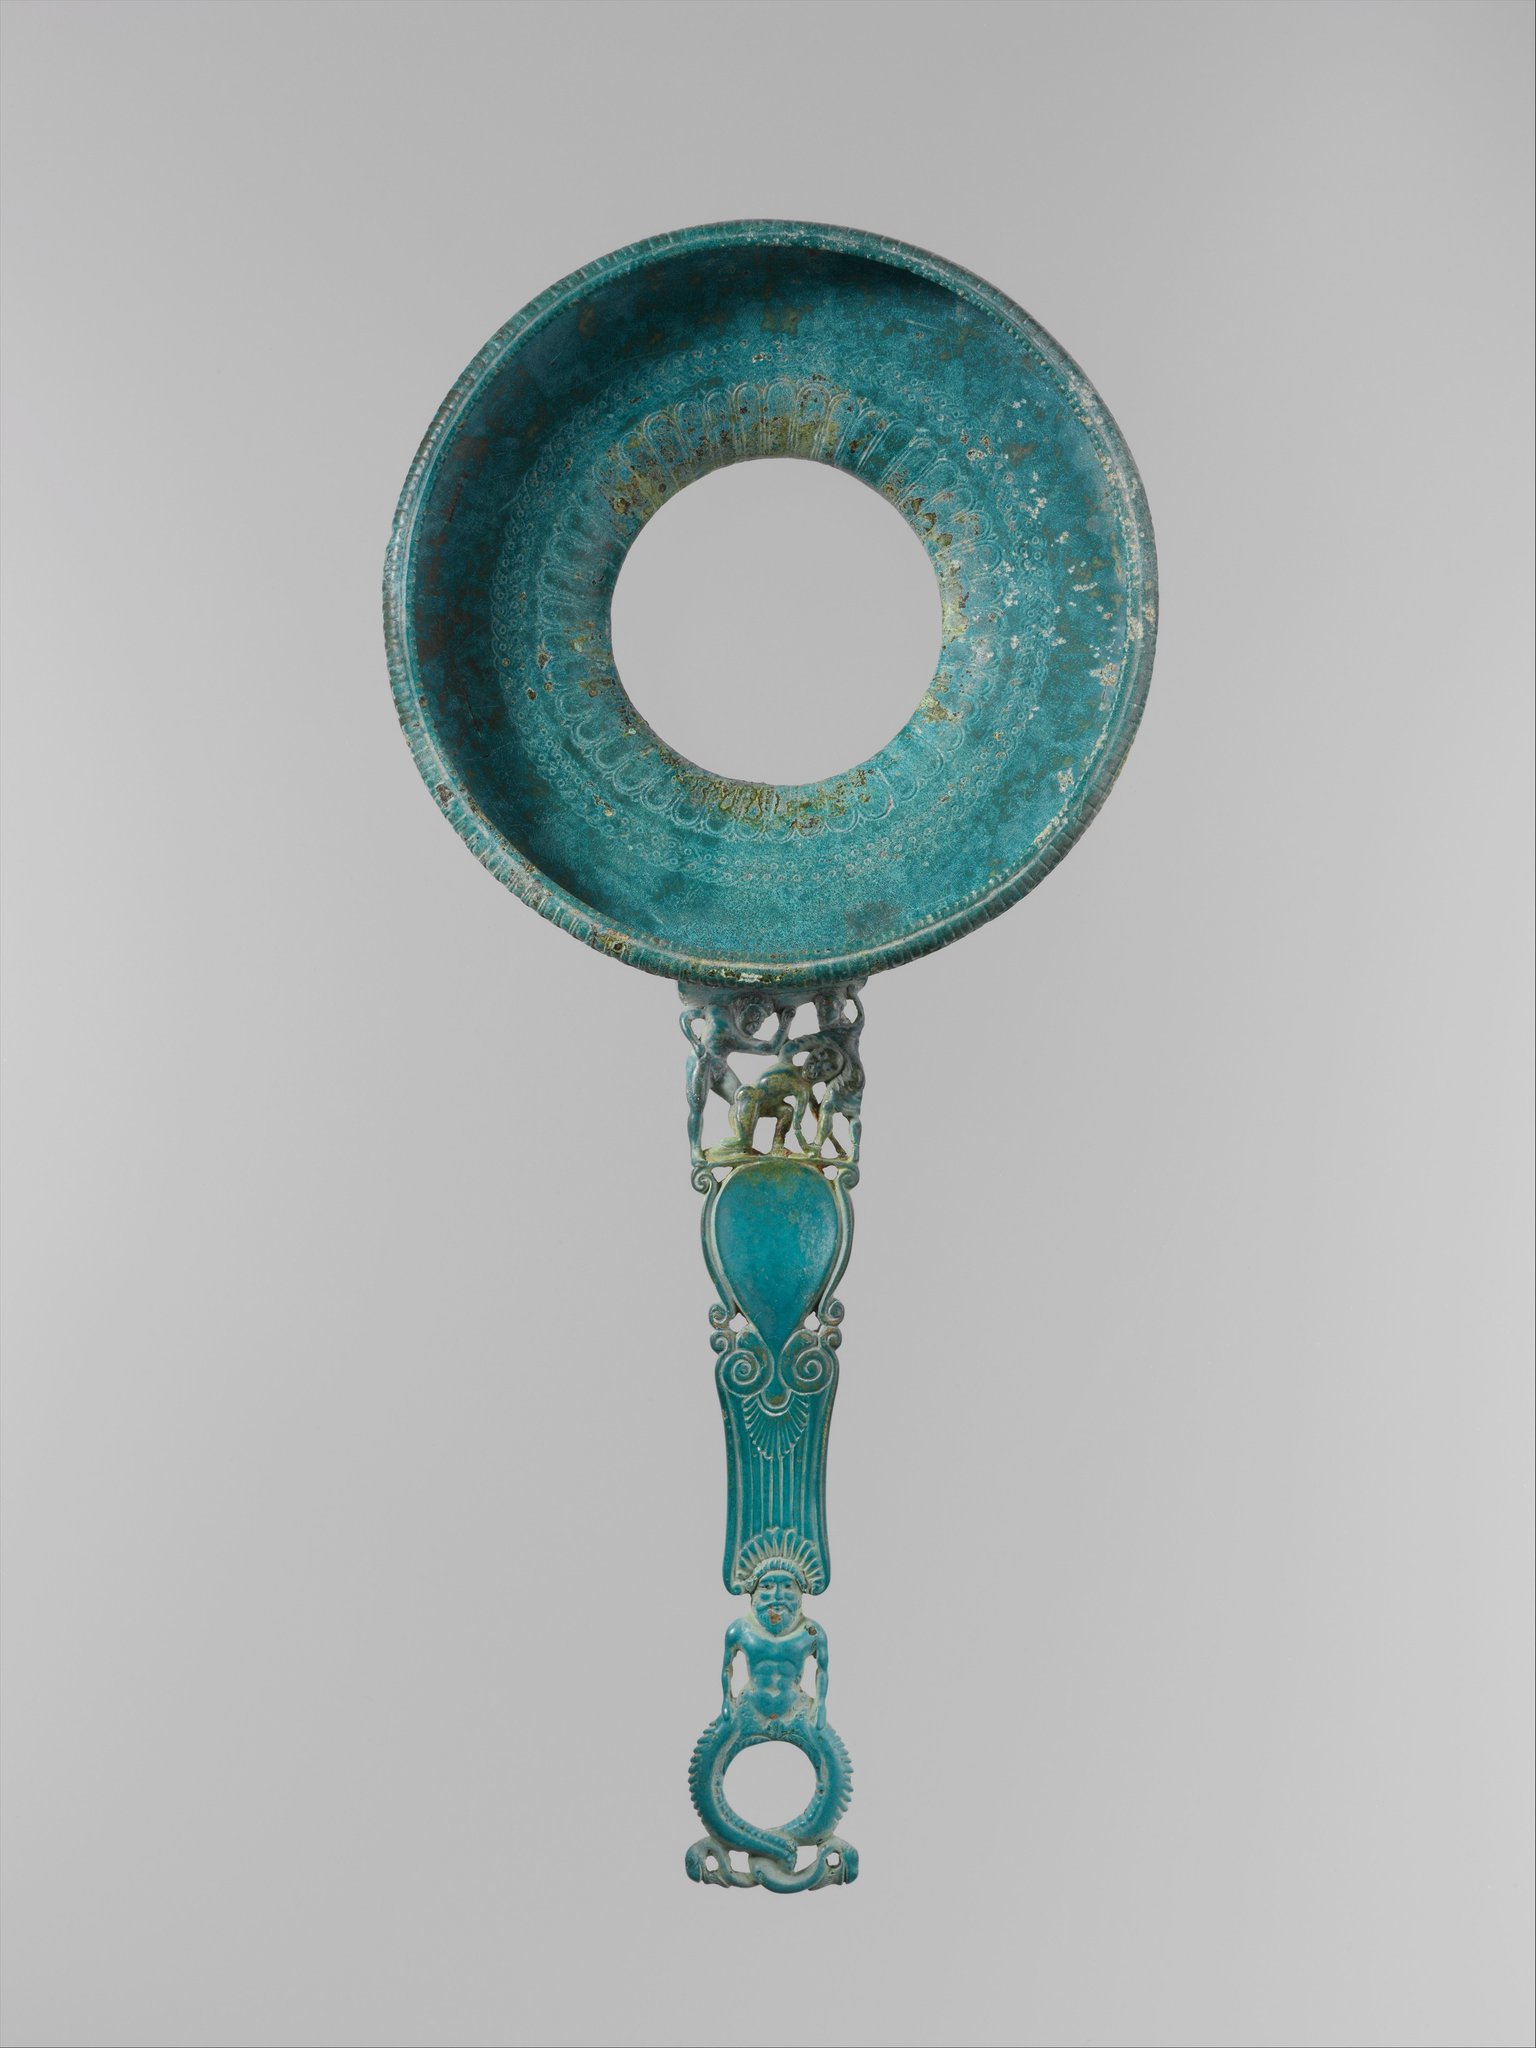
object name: strainer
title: Bronze strainer with openwork handle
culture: etruscan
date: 500-401 BCE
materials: bronze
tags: male nudes,boxing,athletes